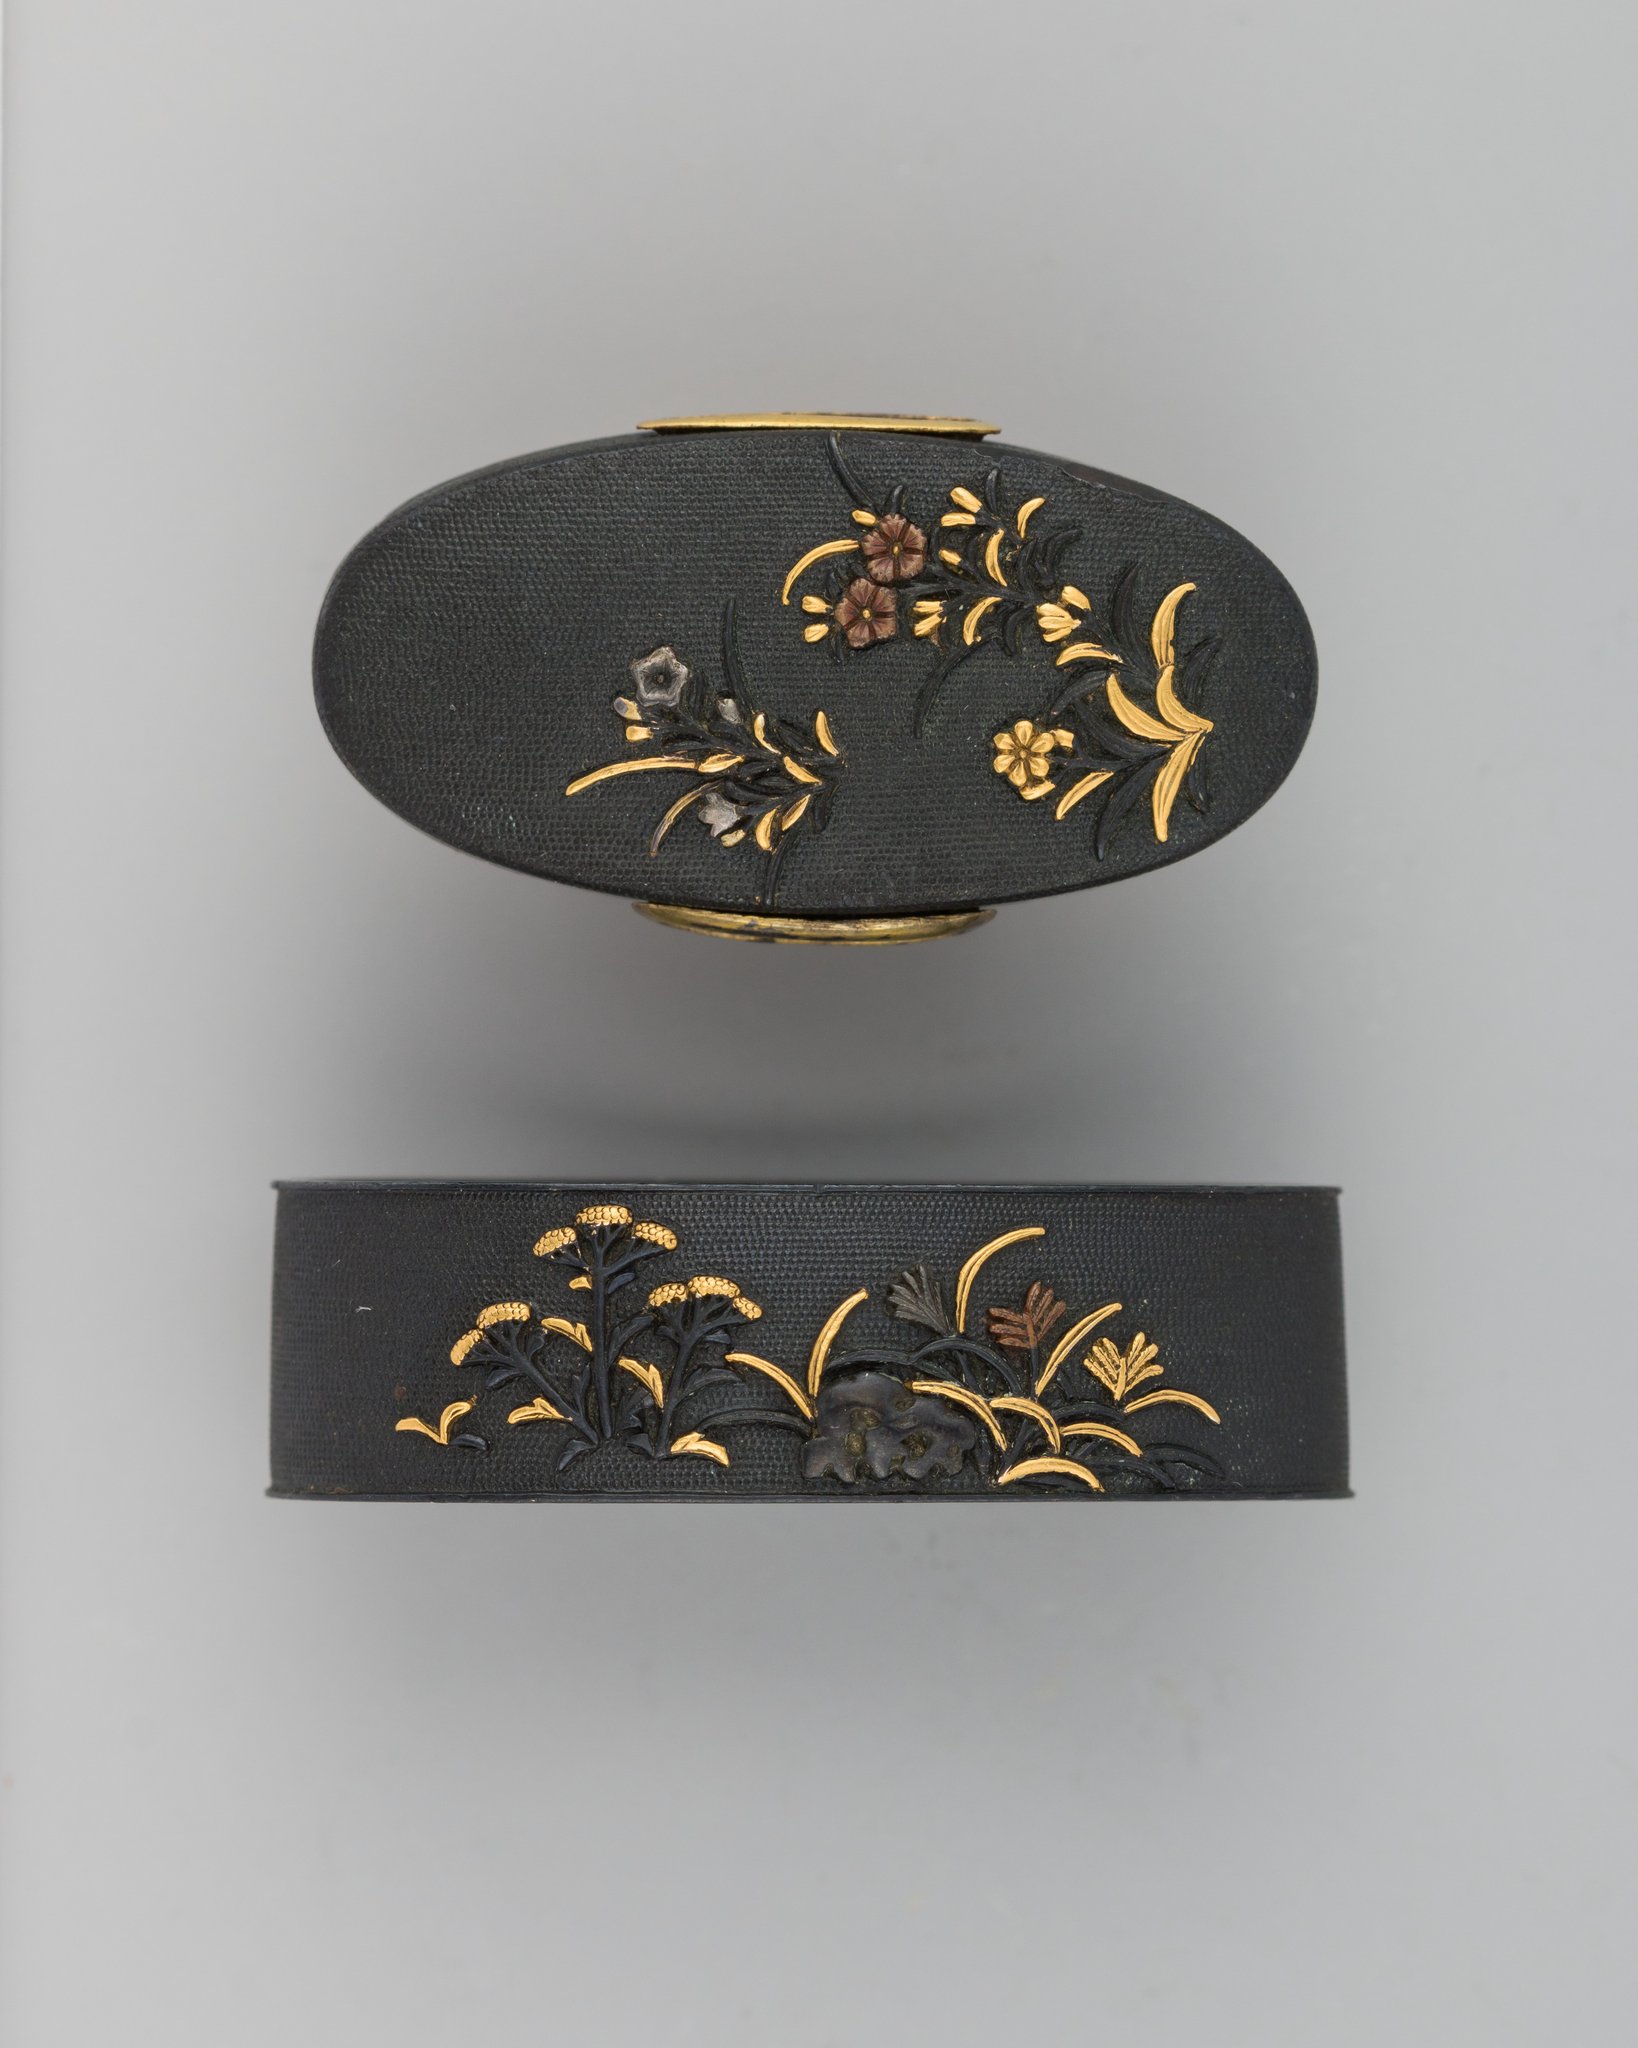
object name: sword hilt collar and pommel fuchigashira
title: Sword-Hilt Collar and Pommel (Fuchigashira)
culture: japanese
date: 1834-1866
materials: gold alloy, gold, silver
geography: japan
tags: flowers,leaves